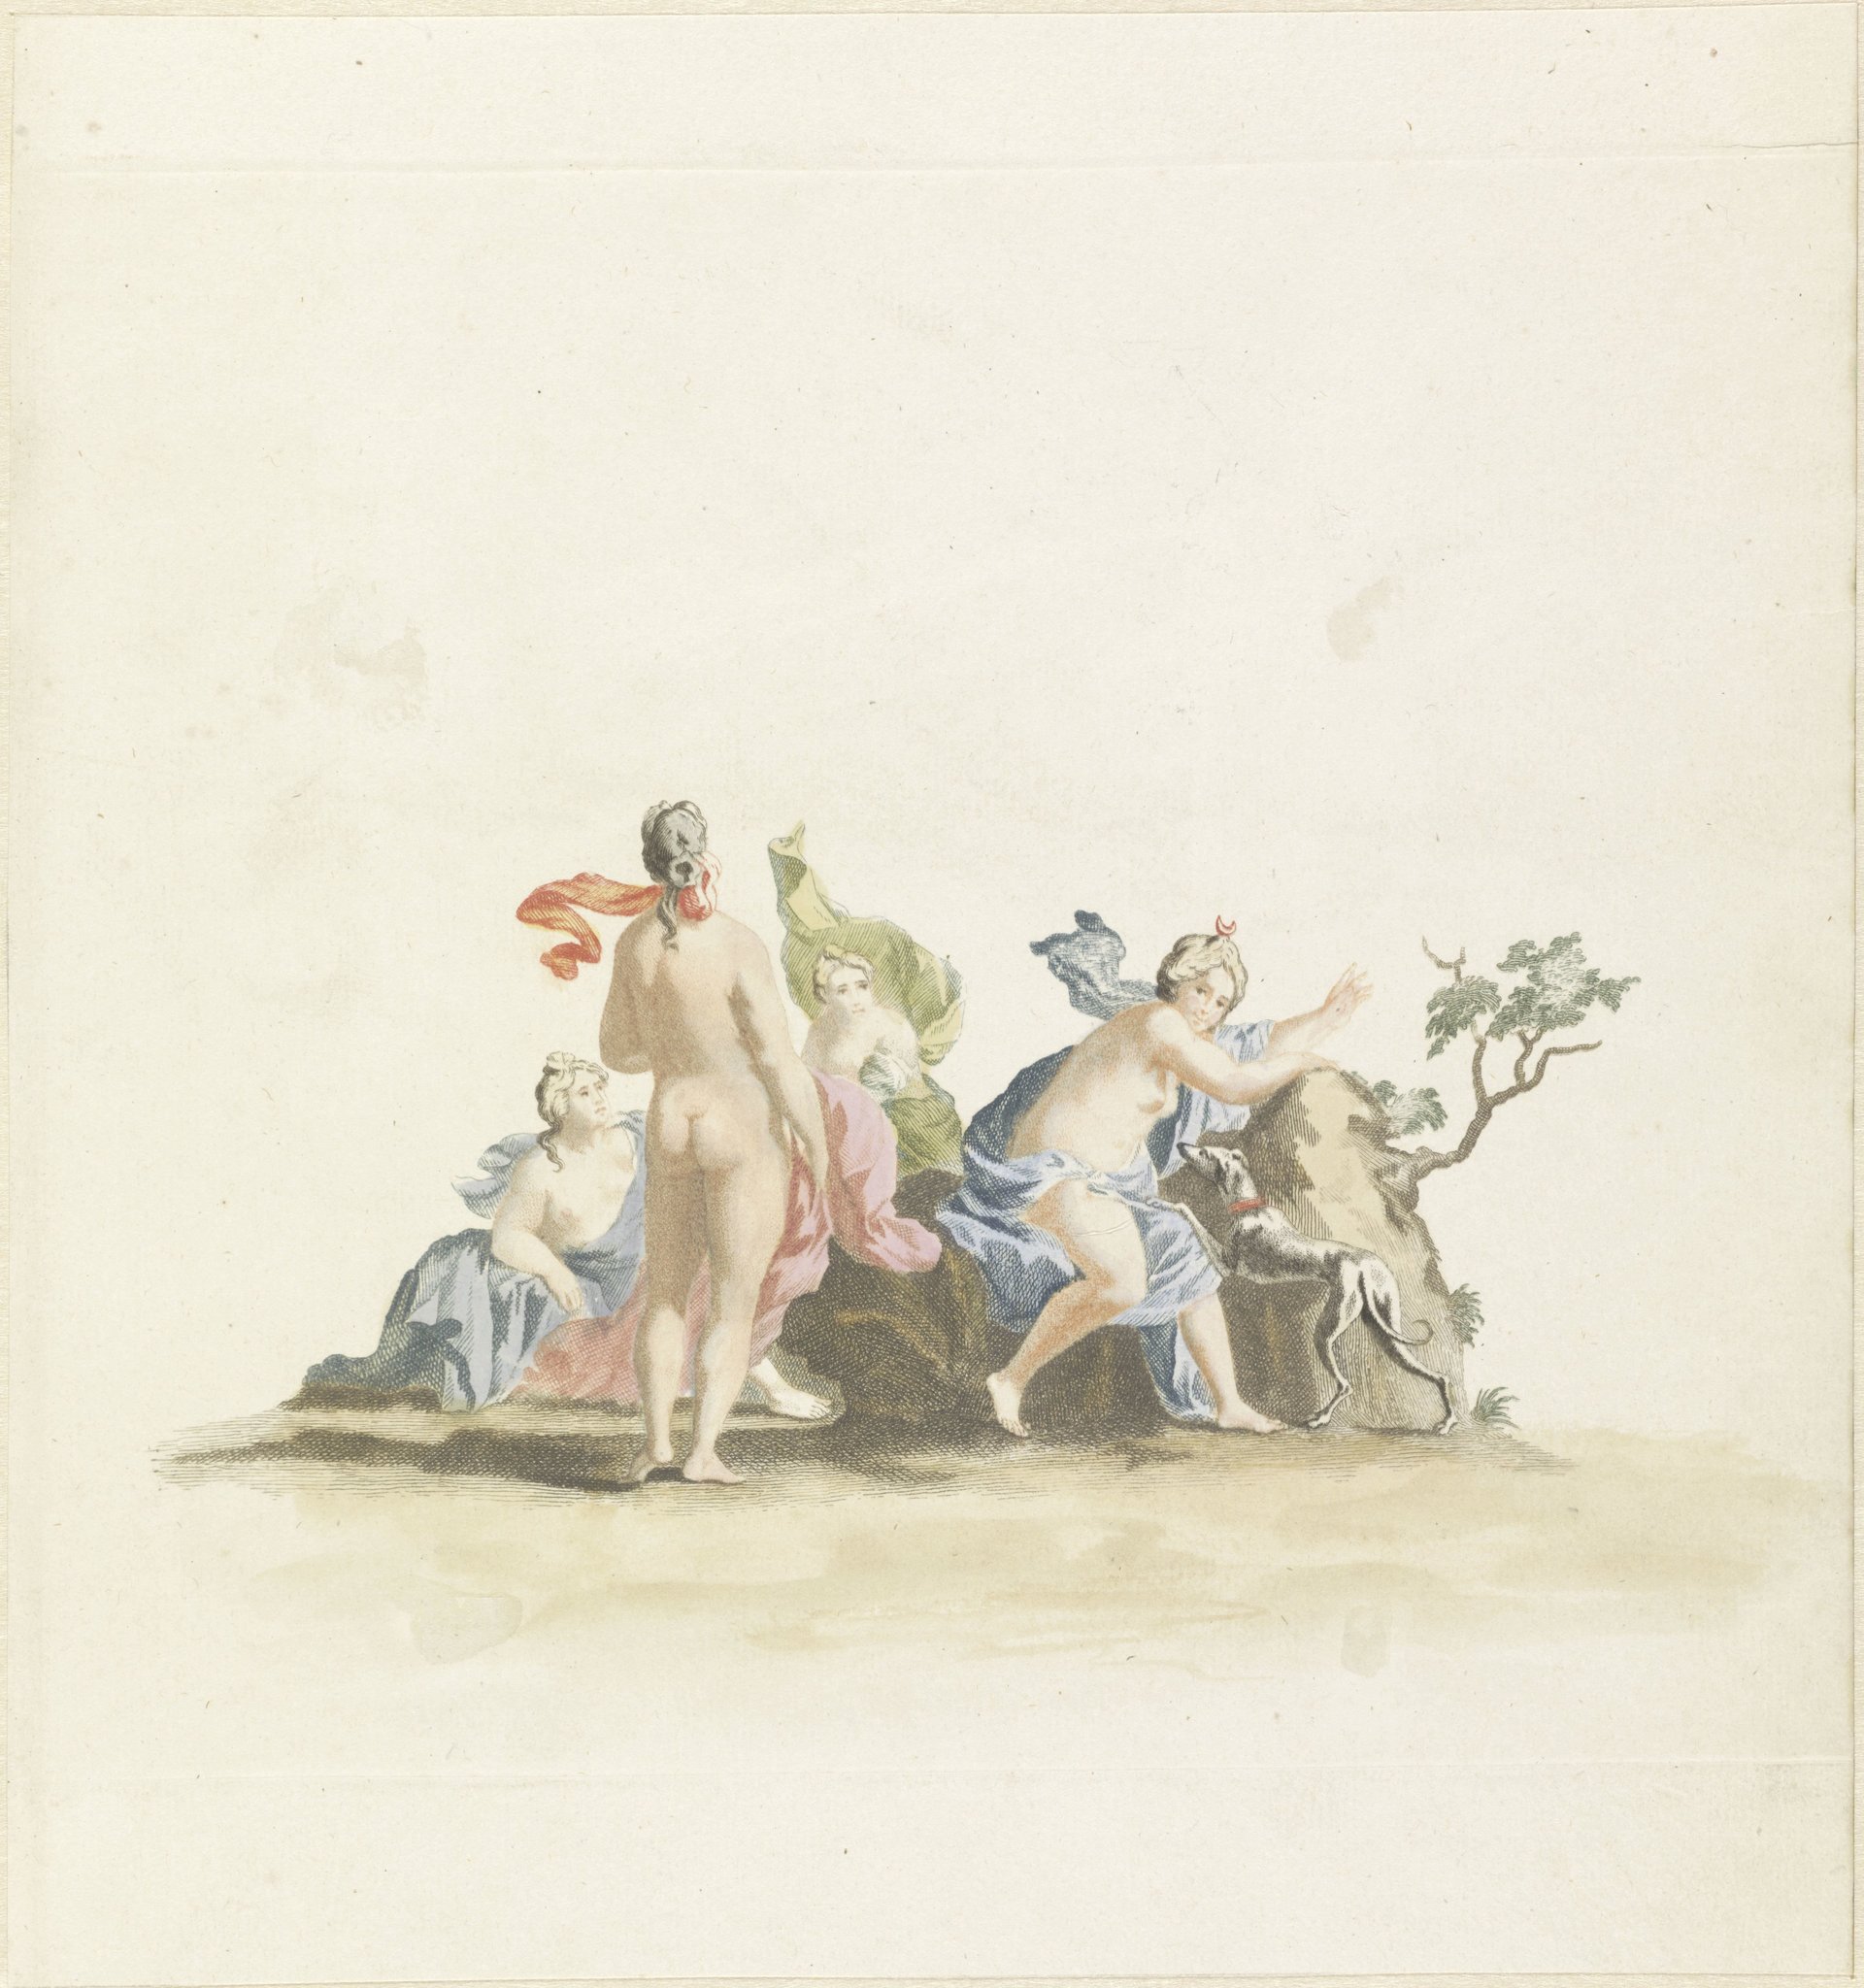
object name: print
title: Diana en haar nimfen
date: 1688-1698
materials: paper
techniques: printing, engraving, hand coloring, lithography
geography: netherlands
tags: companions, nymphs of diana; 'ninfe di diana' (ripa), (story of) diana (artemis)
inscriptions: collector's mark: Lugt 2228, collector's mark: Lugt 2760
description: Diana, maangodin en godin van de jacht, met een jachthond. Naast haar drie nimfen.